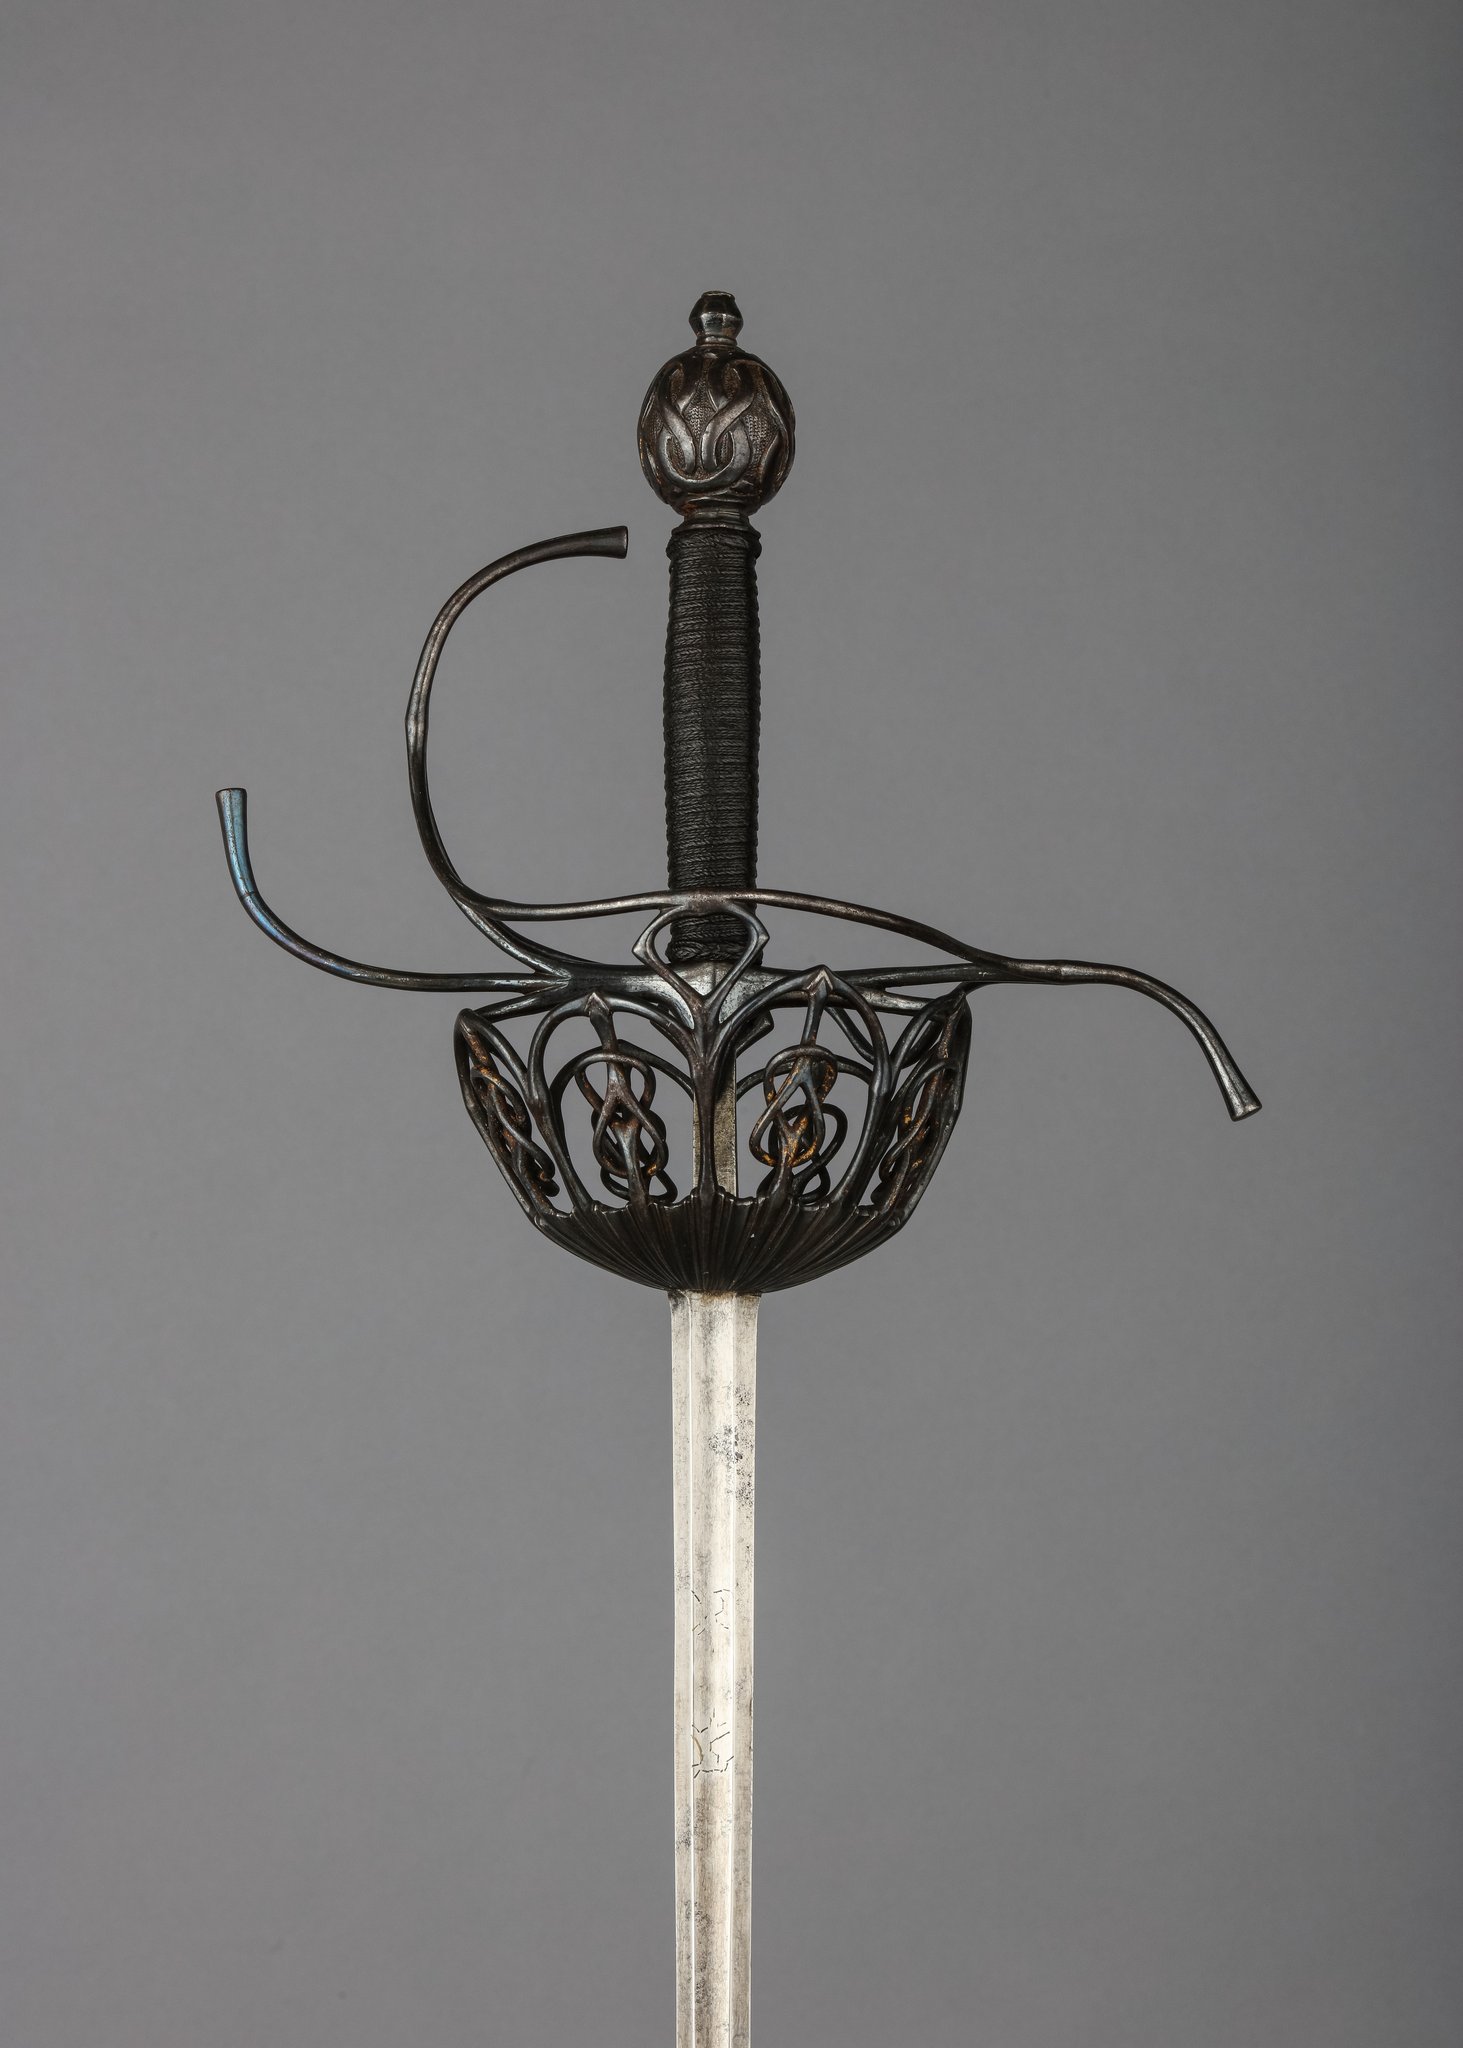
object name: rapier with scabbard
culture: italian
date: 1601-1700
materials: brass, gold, leather, steel, velvet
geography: italy